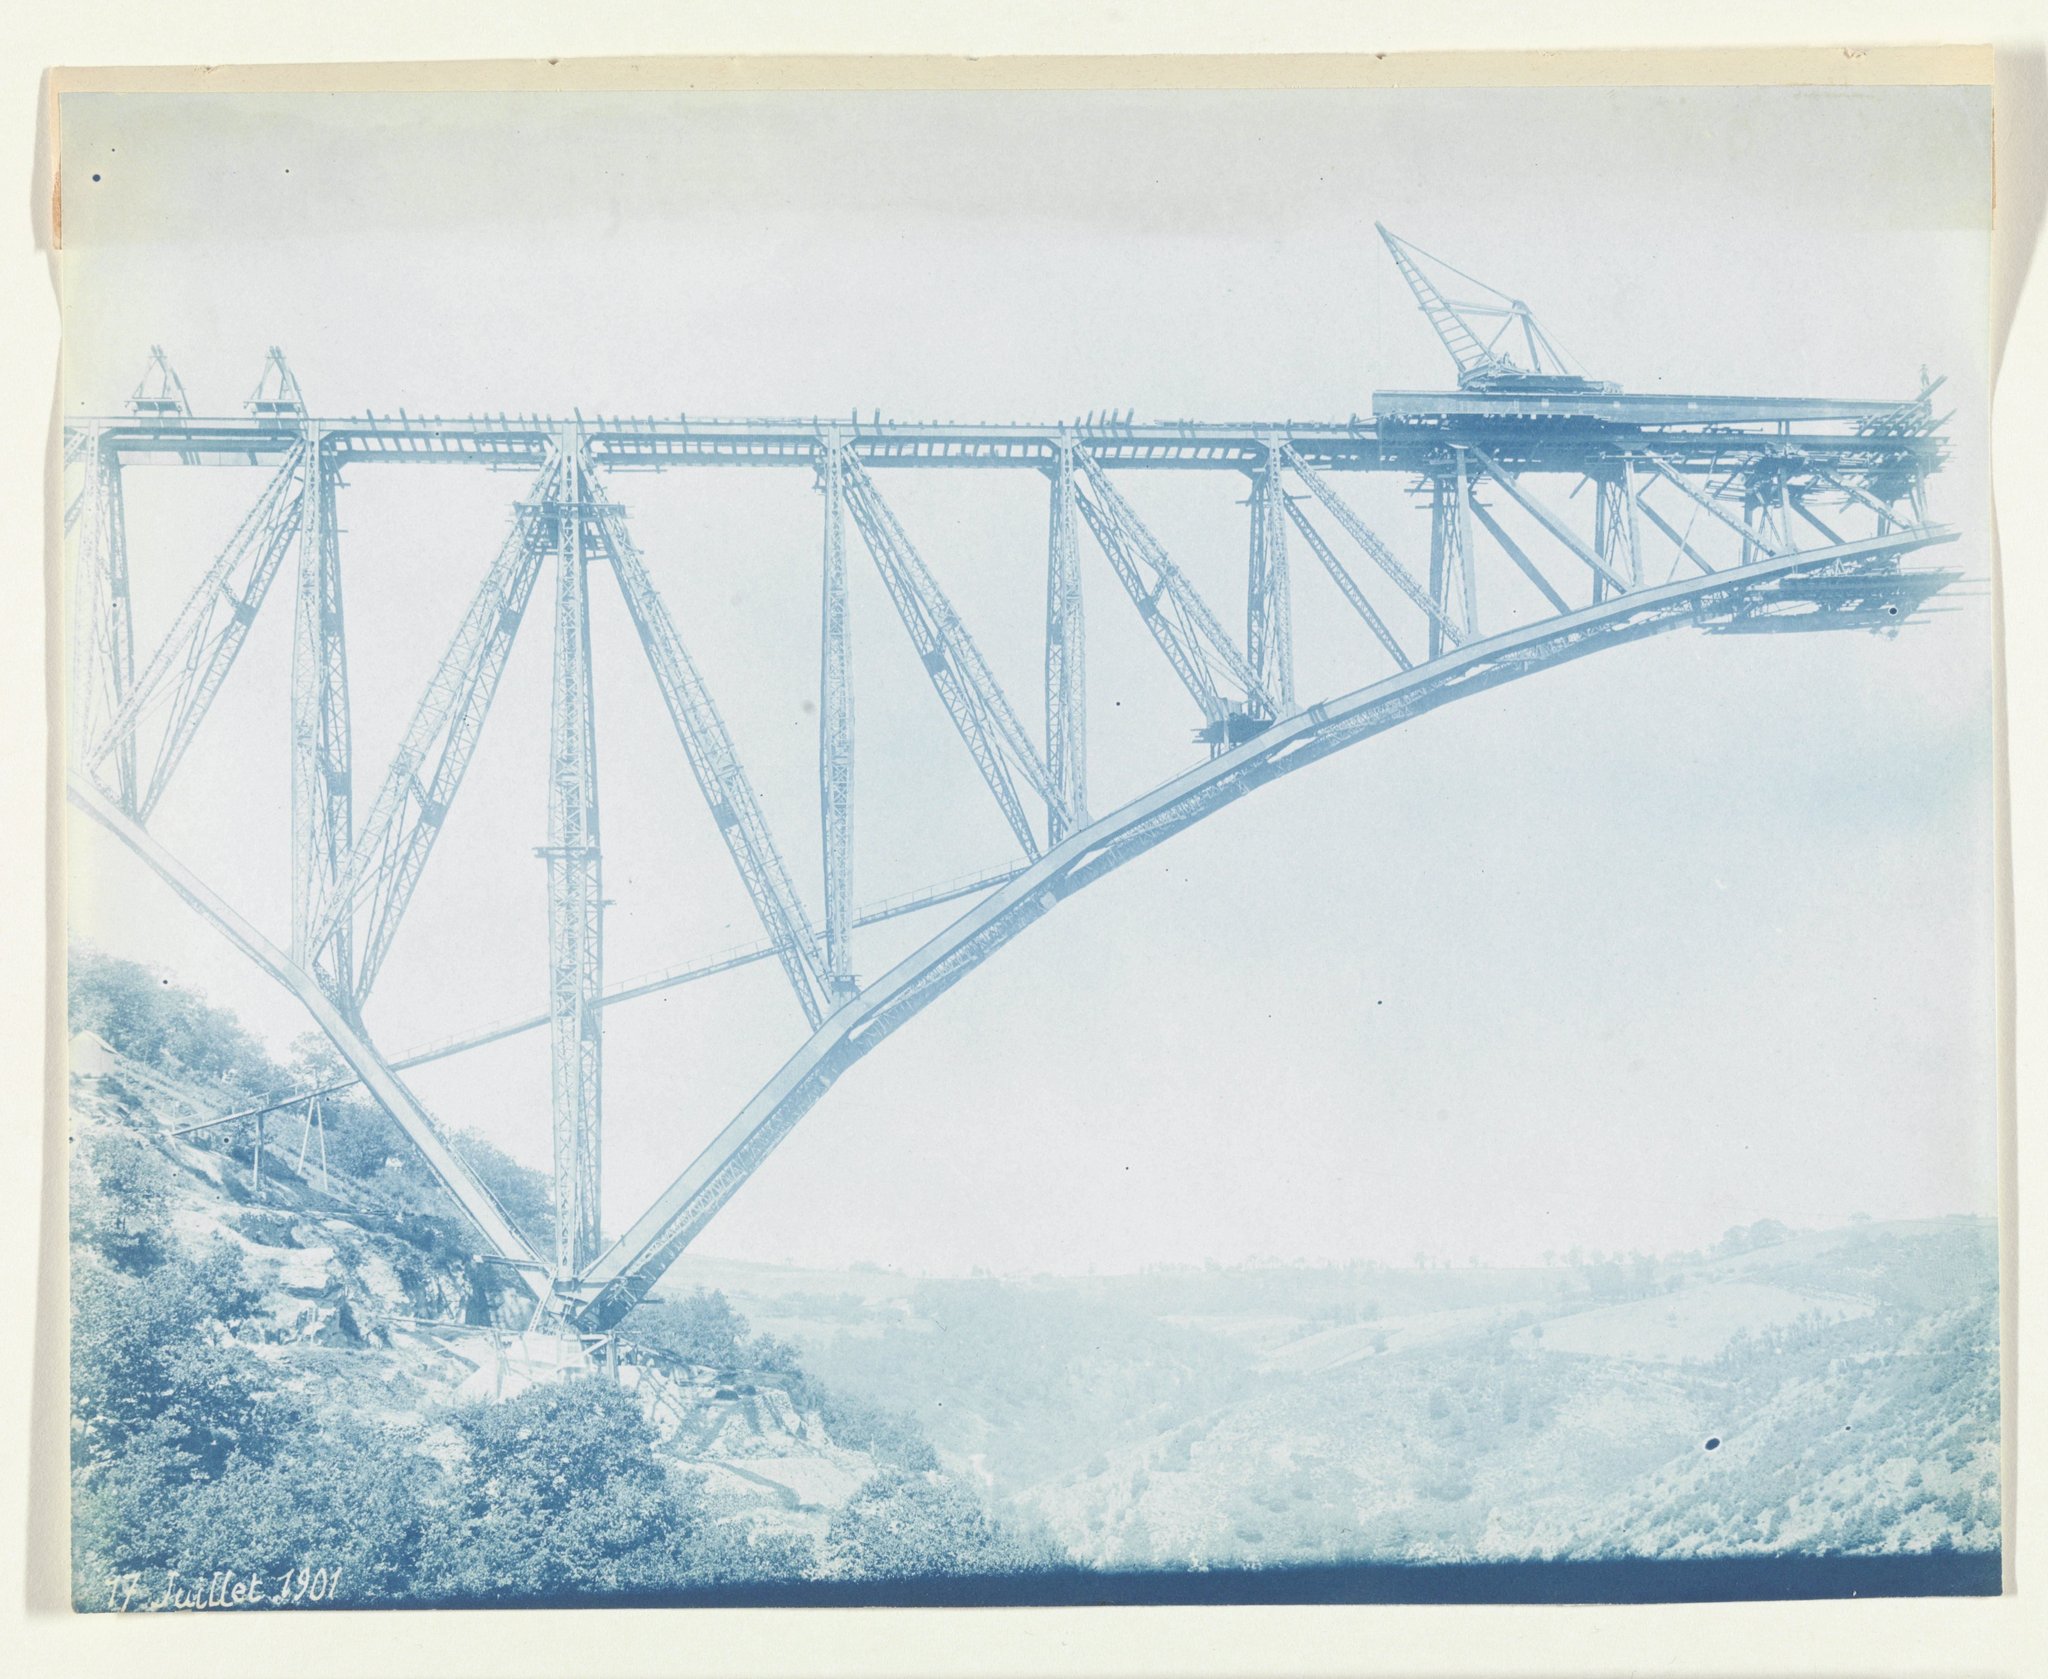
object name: photograph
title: Aanleg van het Viaur Viaduct in Frankrijk door de Societé de Construction des Battignolles, 17 juli 1901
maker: Anonymous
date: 1901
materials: photographic support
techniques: cyanotype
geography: france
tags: viaduct, making the overground structures (~ building activities)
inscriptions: date